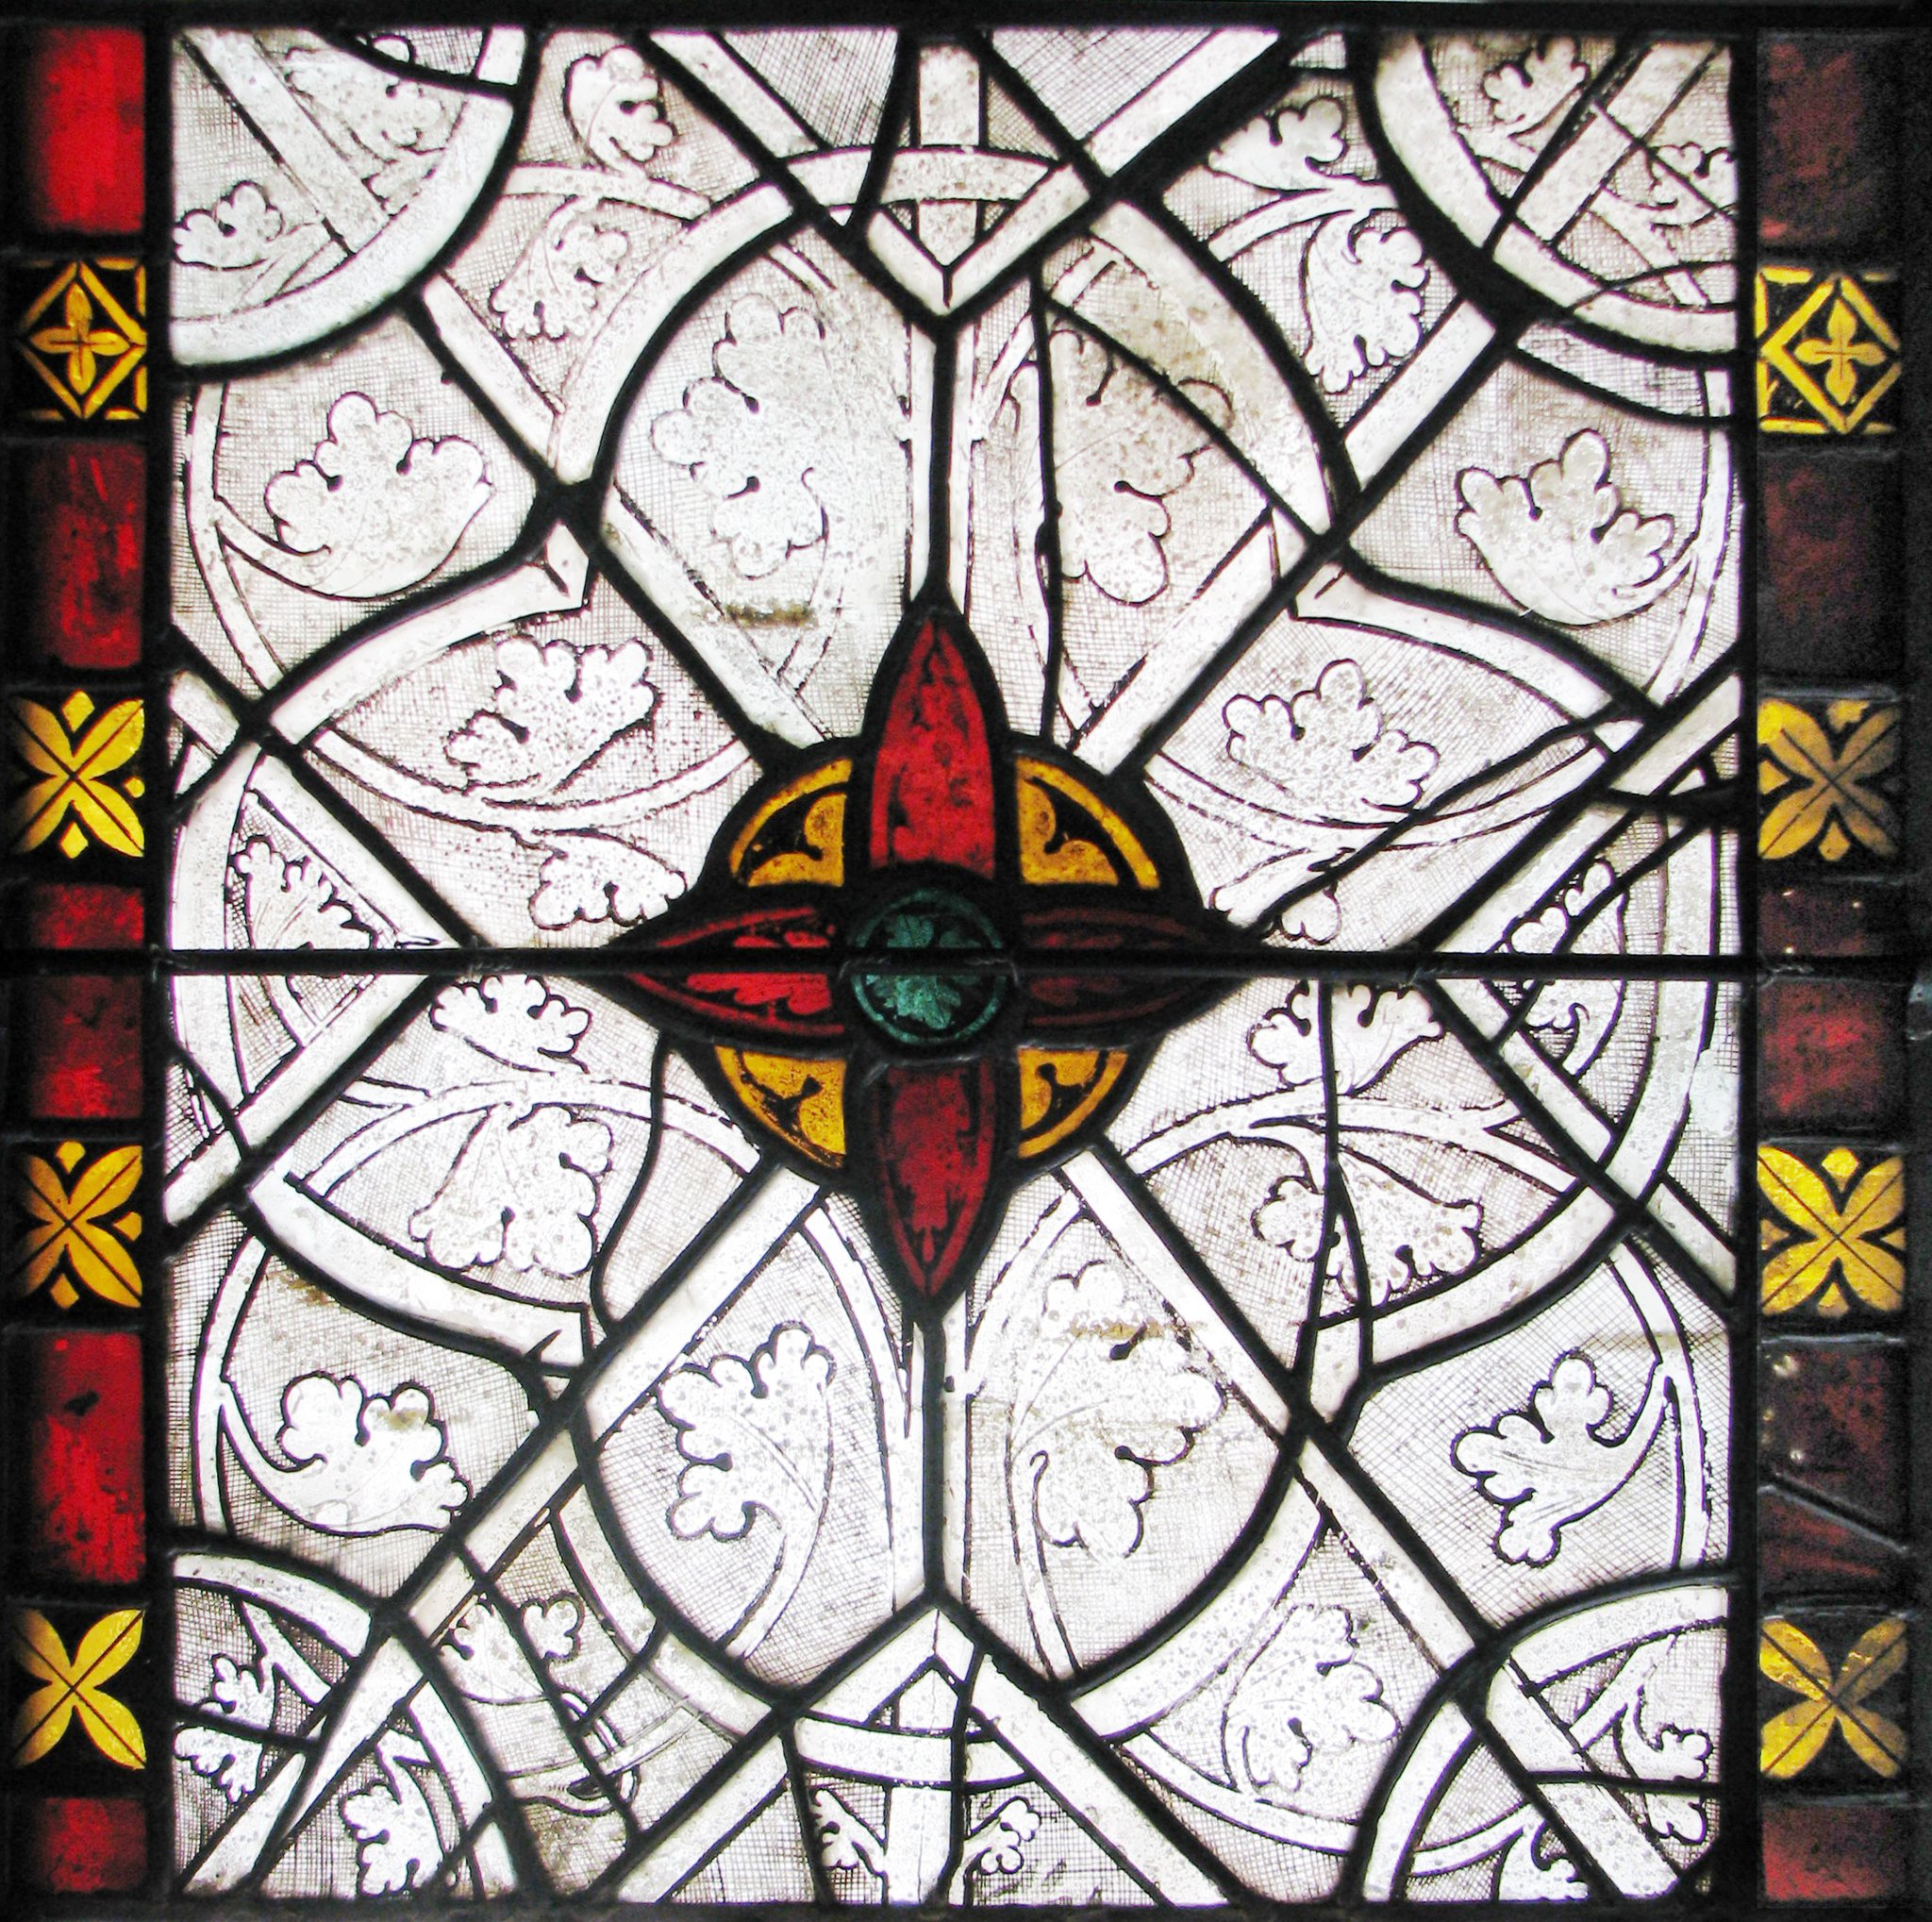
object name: panel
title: Grisaille Panel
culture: french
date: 1270-1280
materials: glass, metal, paint, pigment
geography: france